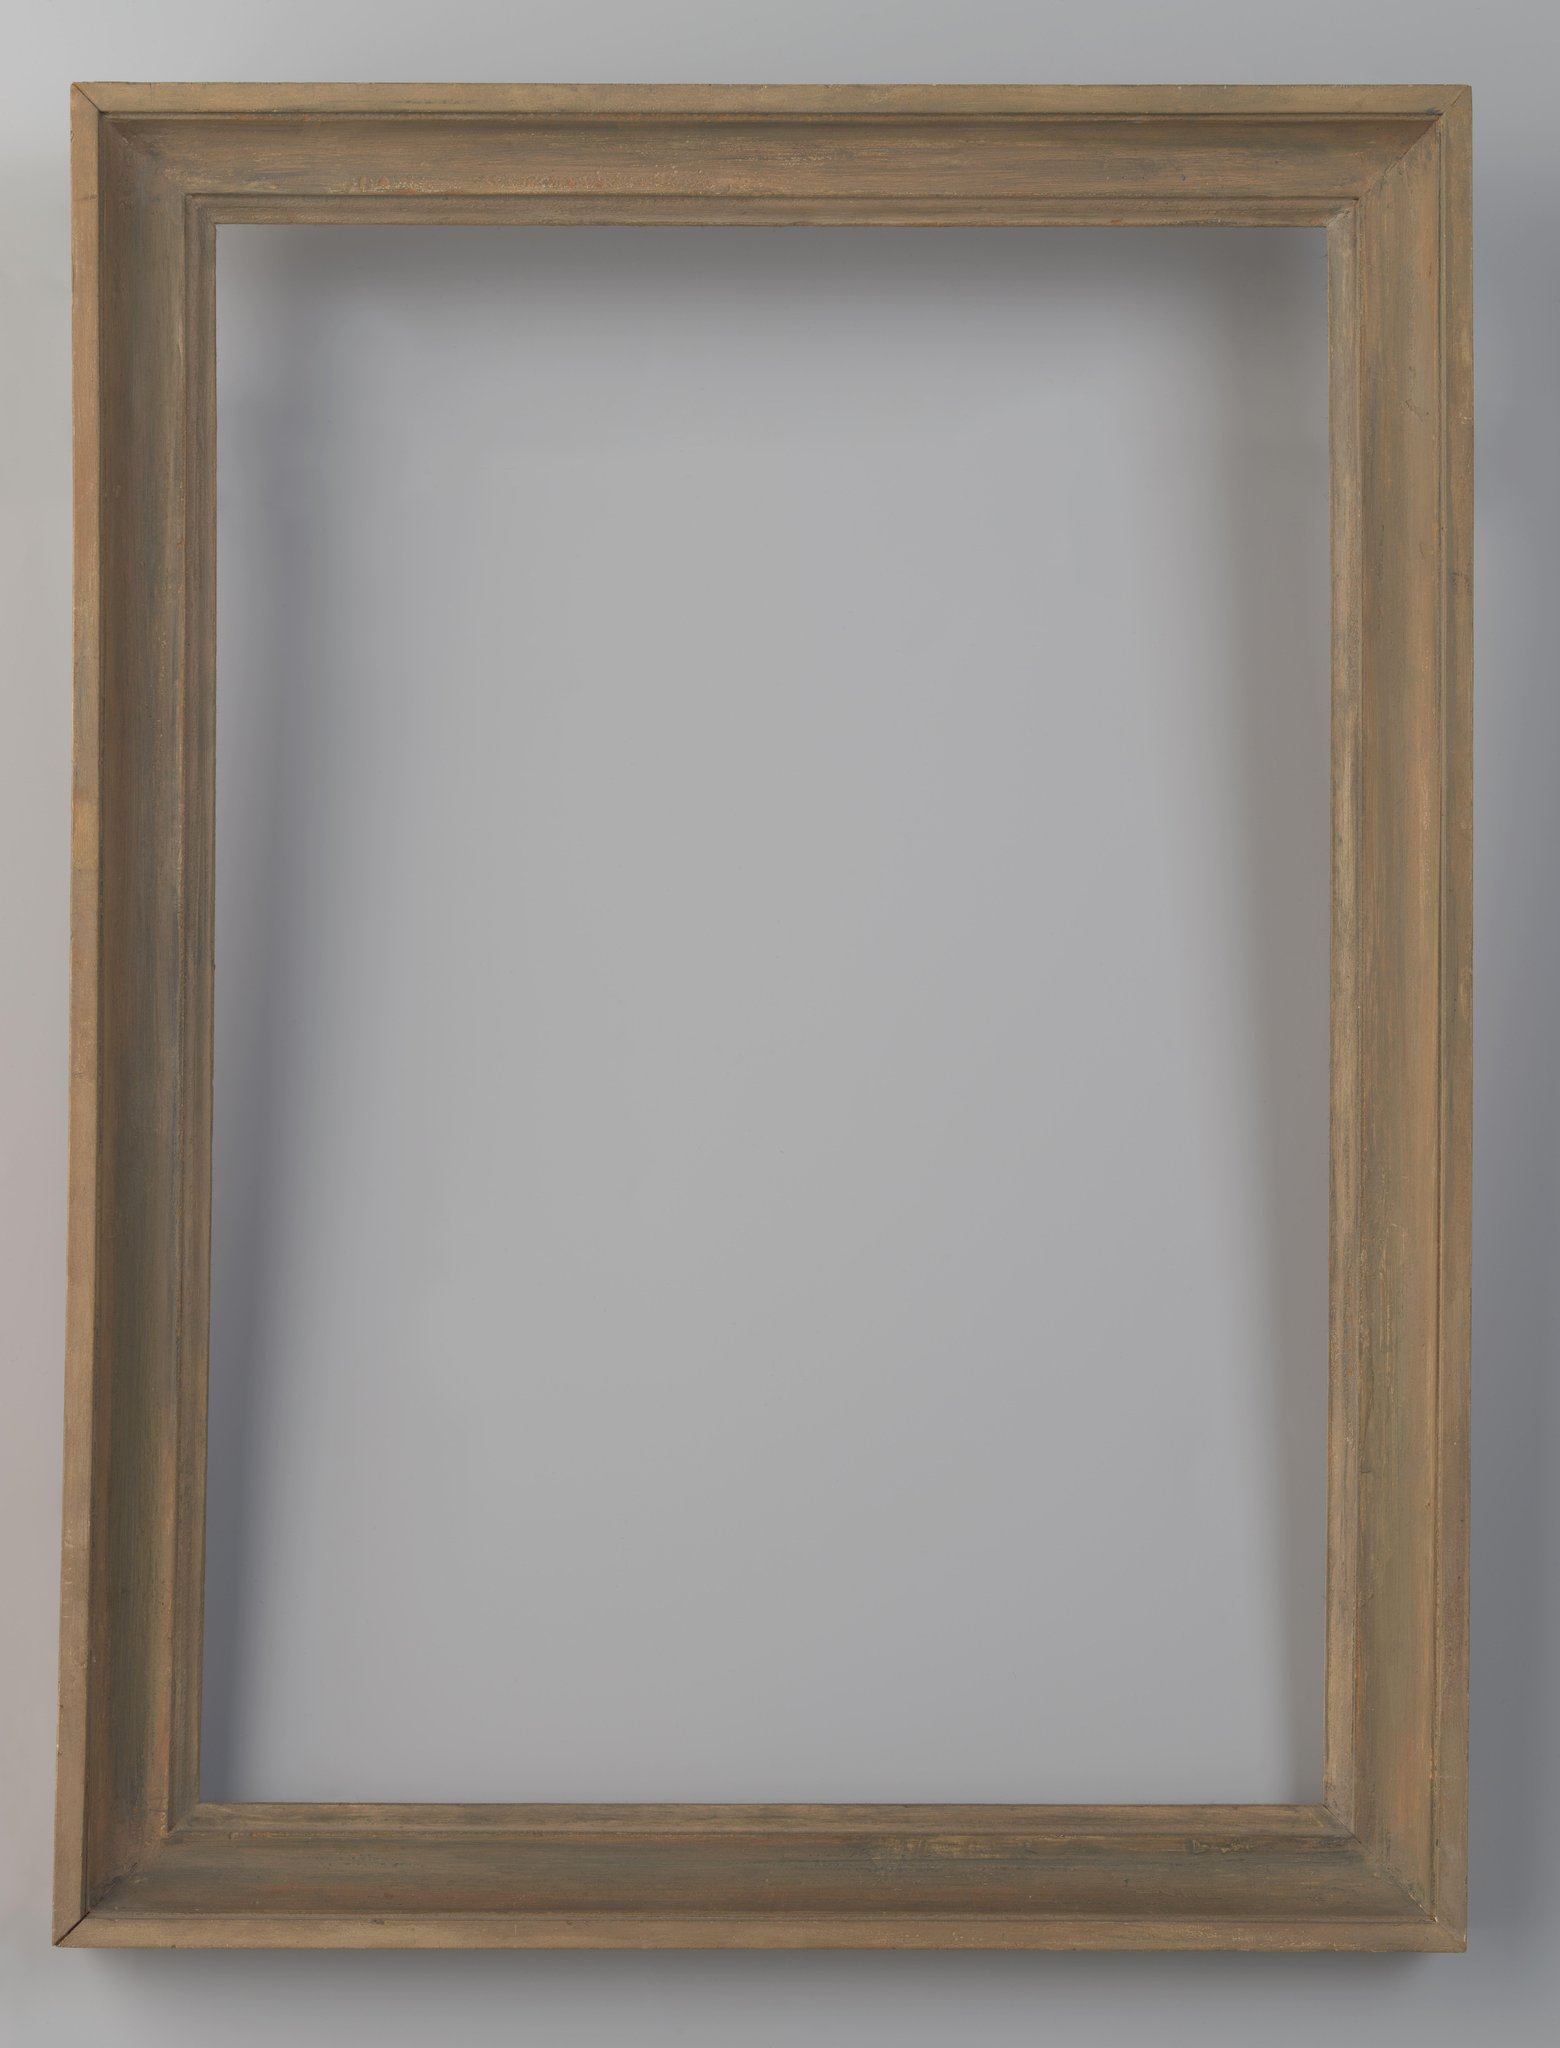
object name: frame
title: Lijst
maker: Anonymous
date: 1946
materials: wood